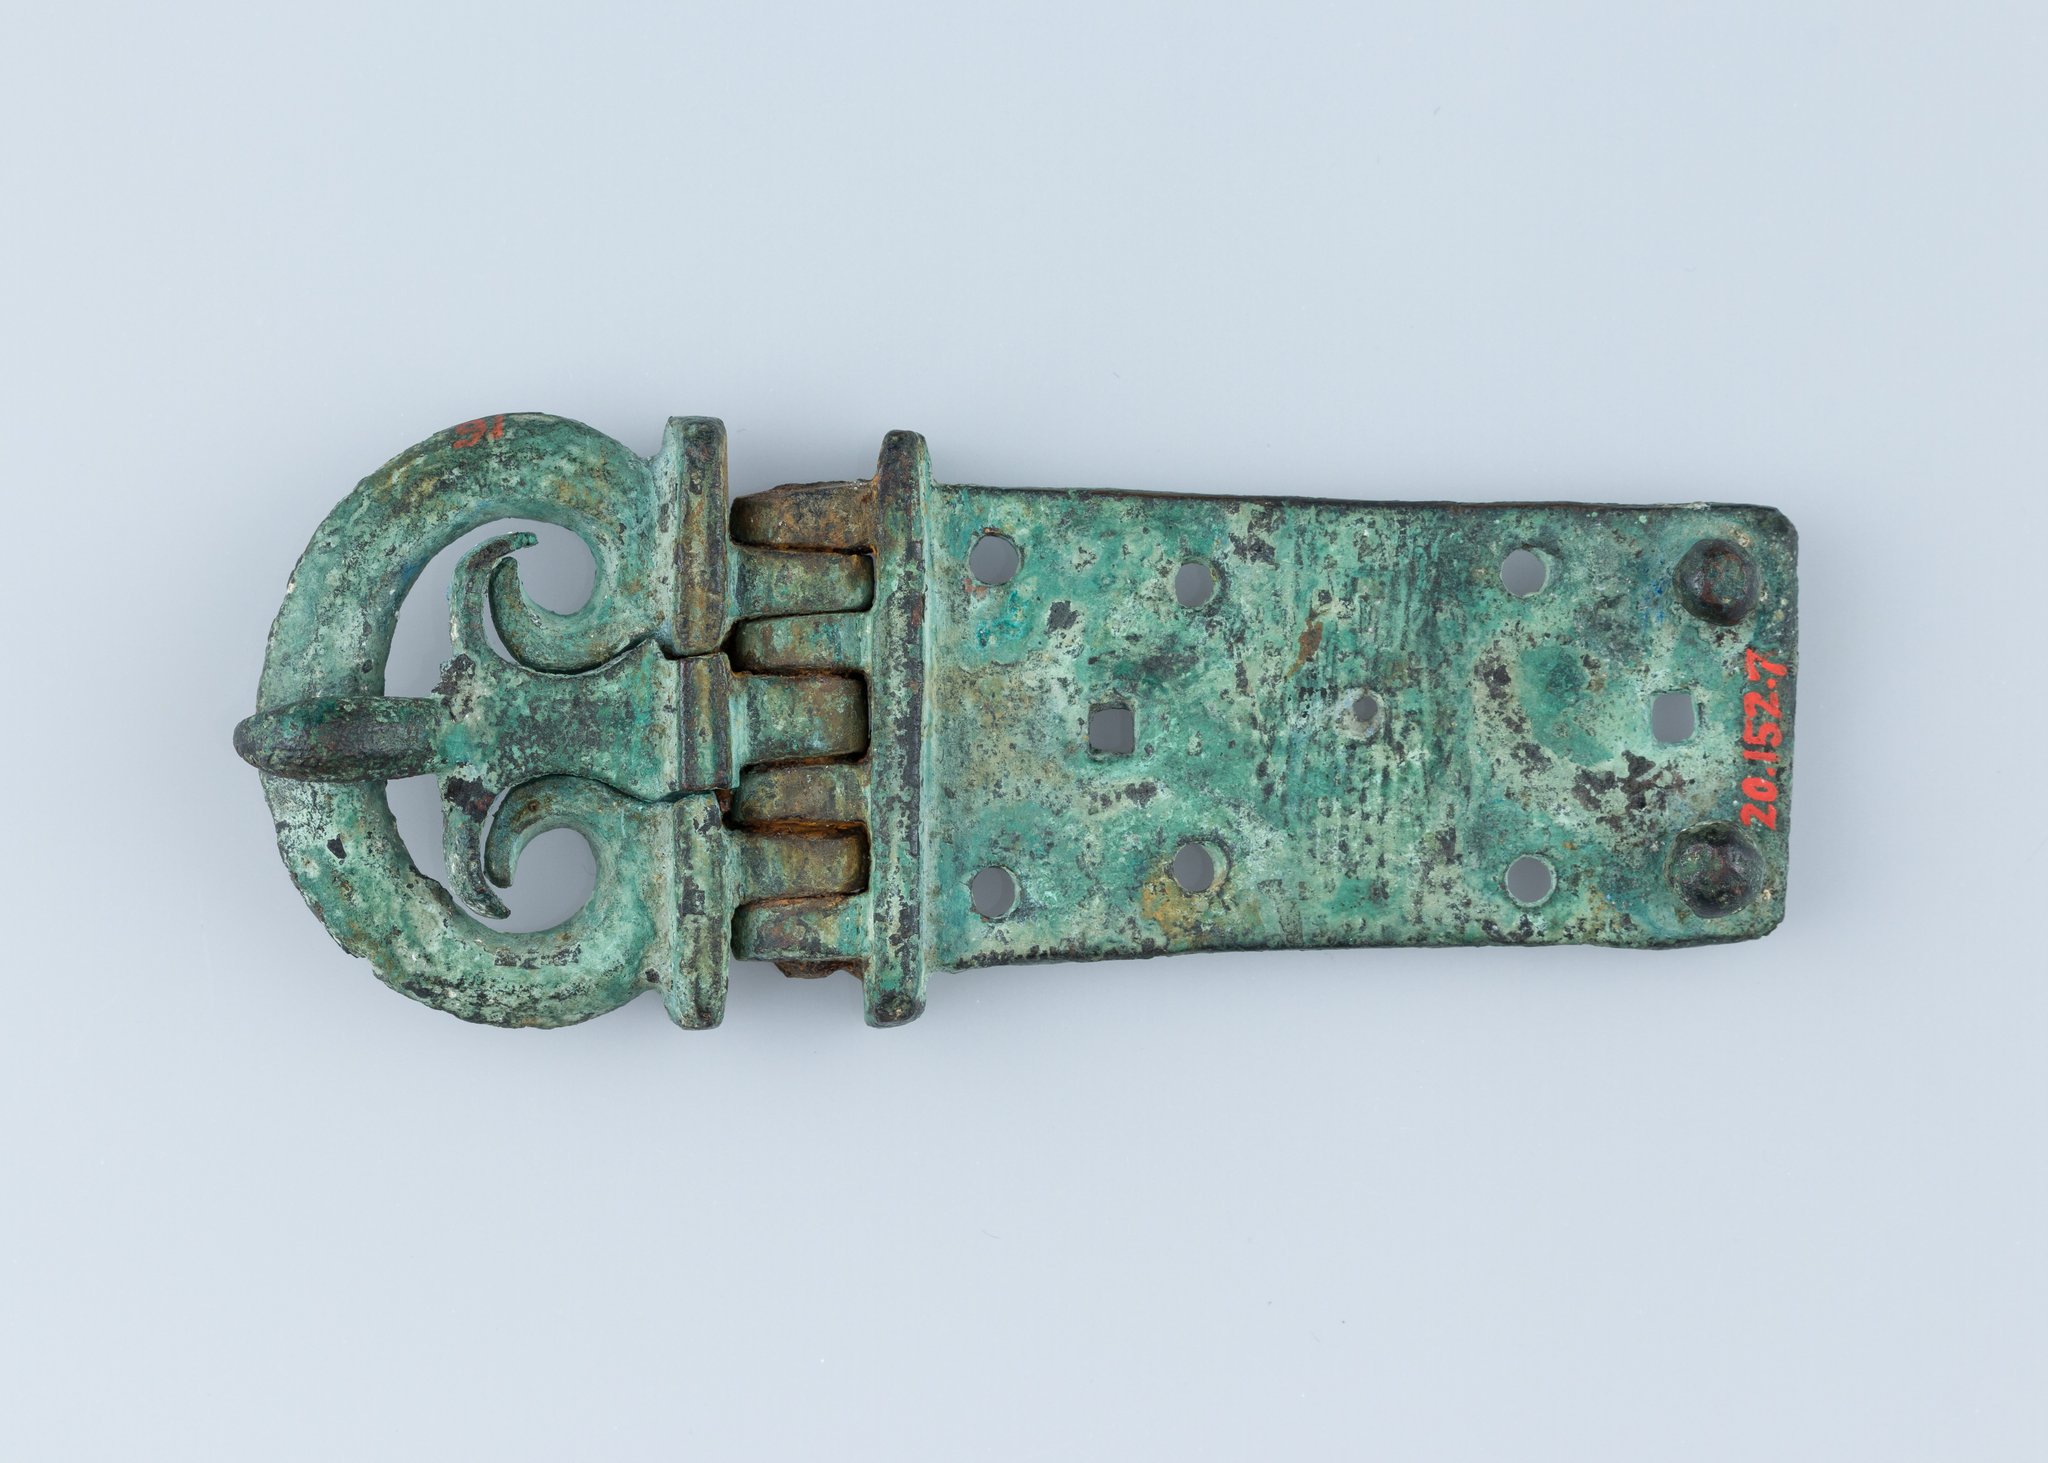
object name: buckle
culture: roman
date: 1-100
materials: bronze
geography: italy